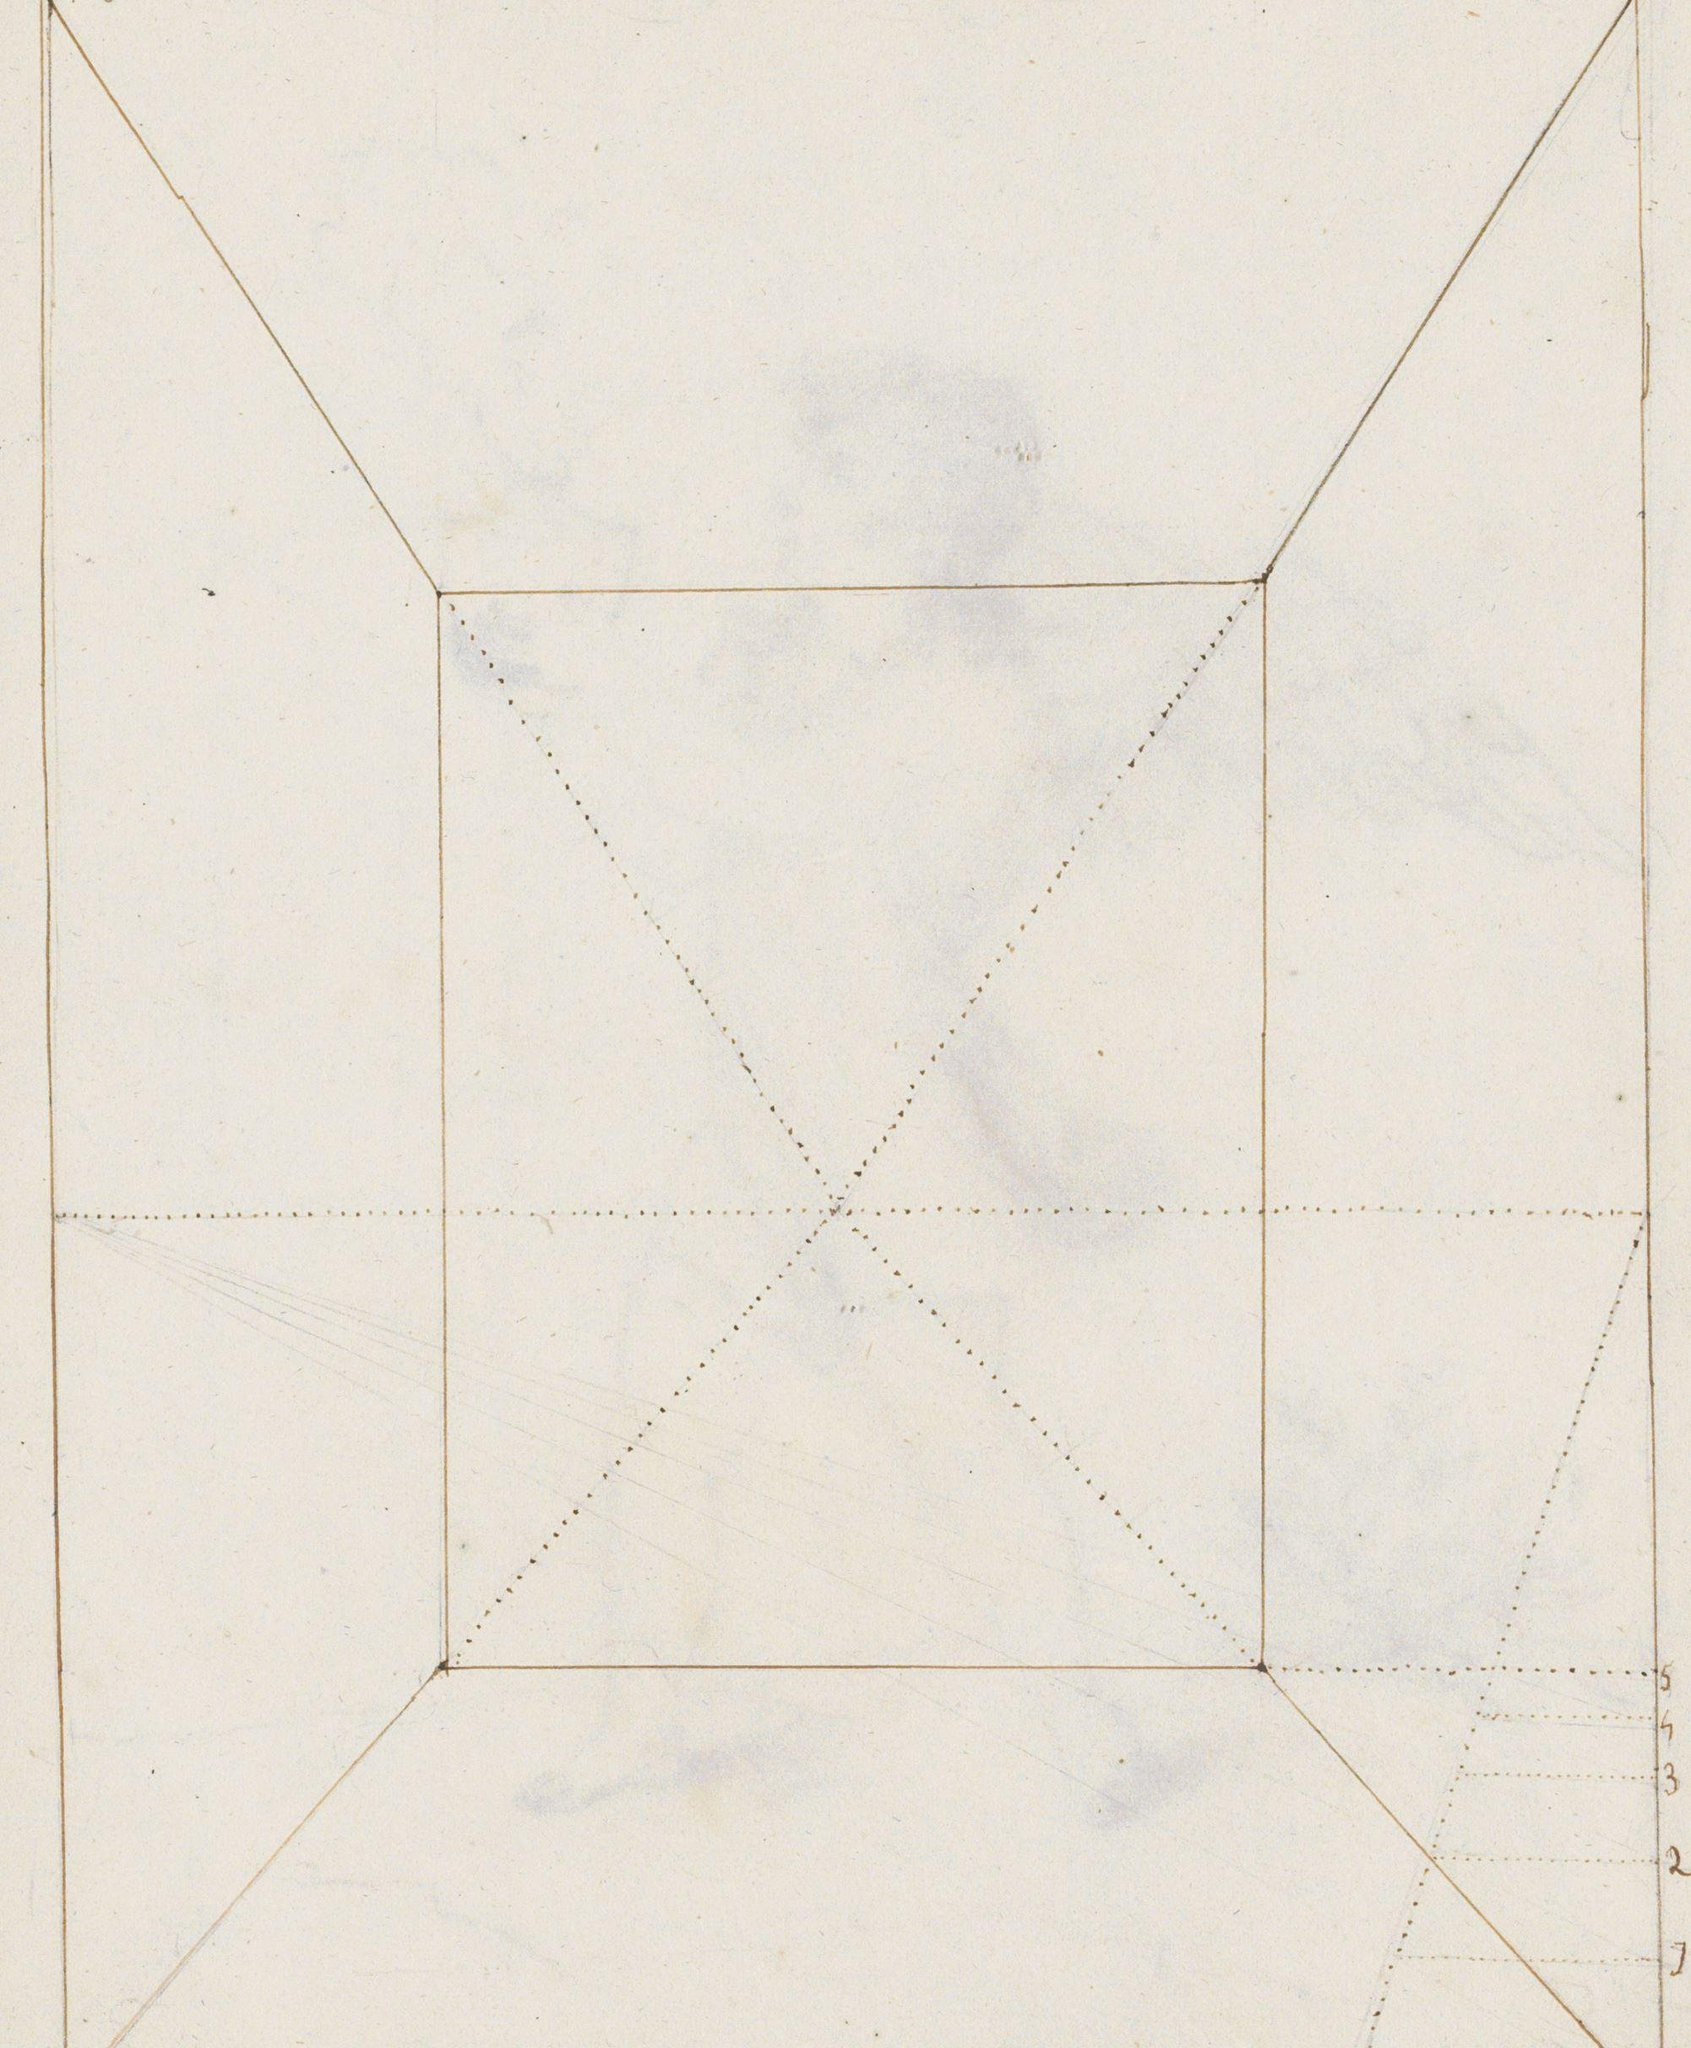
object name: sketchbook leaf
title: Perspectiefoefening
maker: jonkvrouw catharina kemper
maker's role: draughtsman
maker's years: 1801-1871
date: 1813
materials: ink, paper, pencil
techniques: pen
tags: mathematical perspective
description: Blad 18 recto uit een schetsboek met 91 bladen.